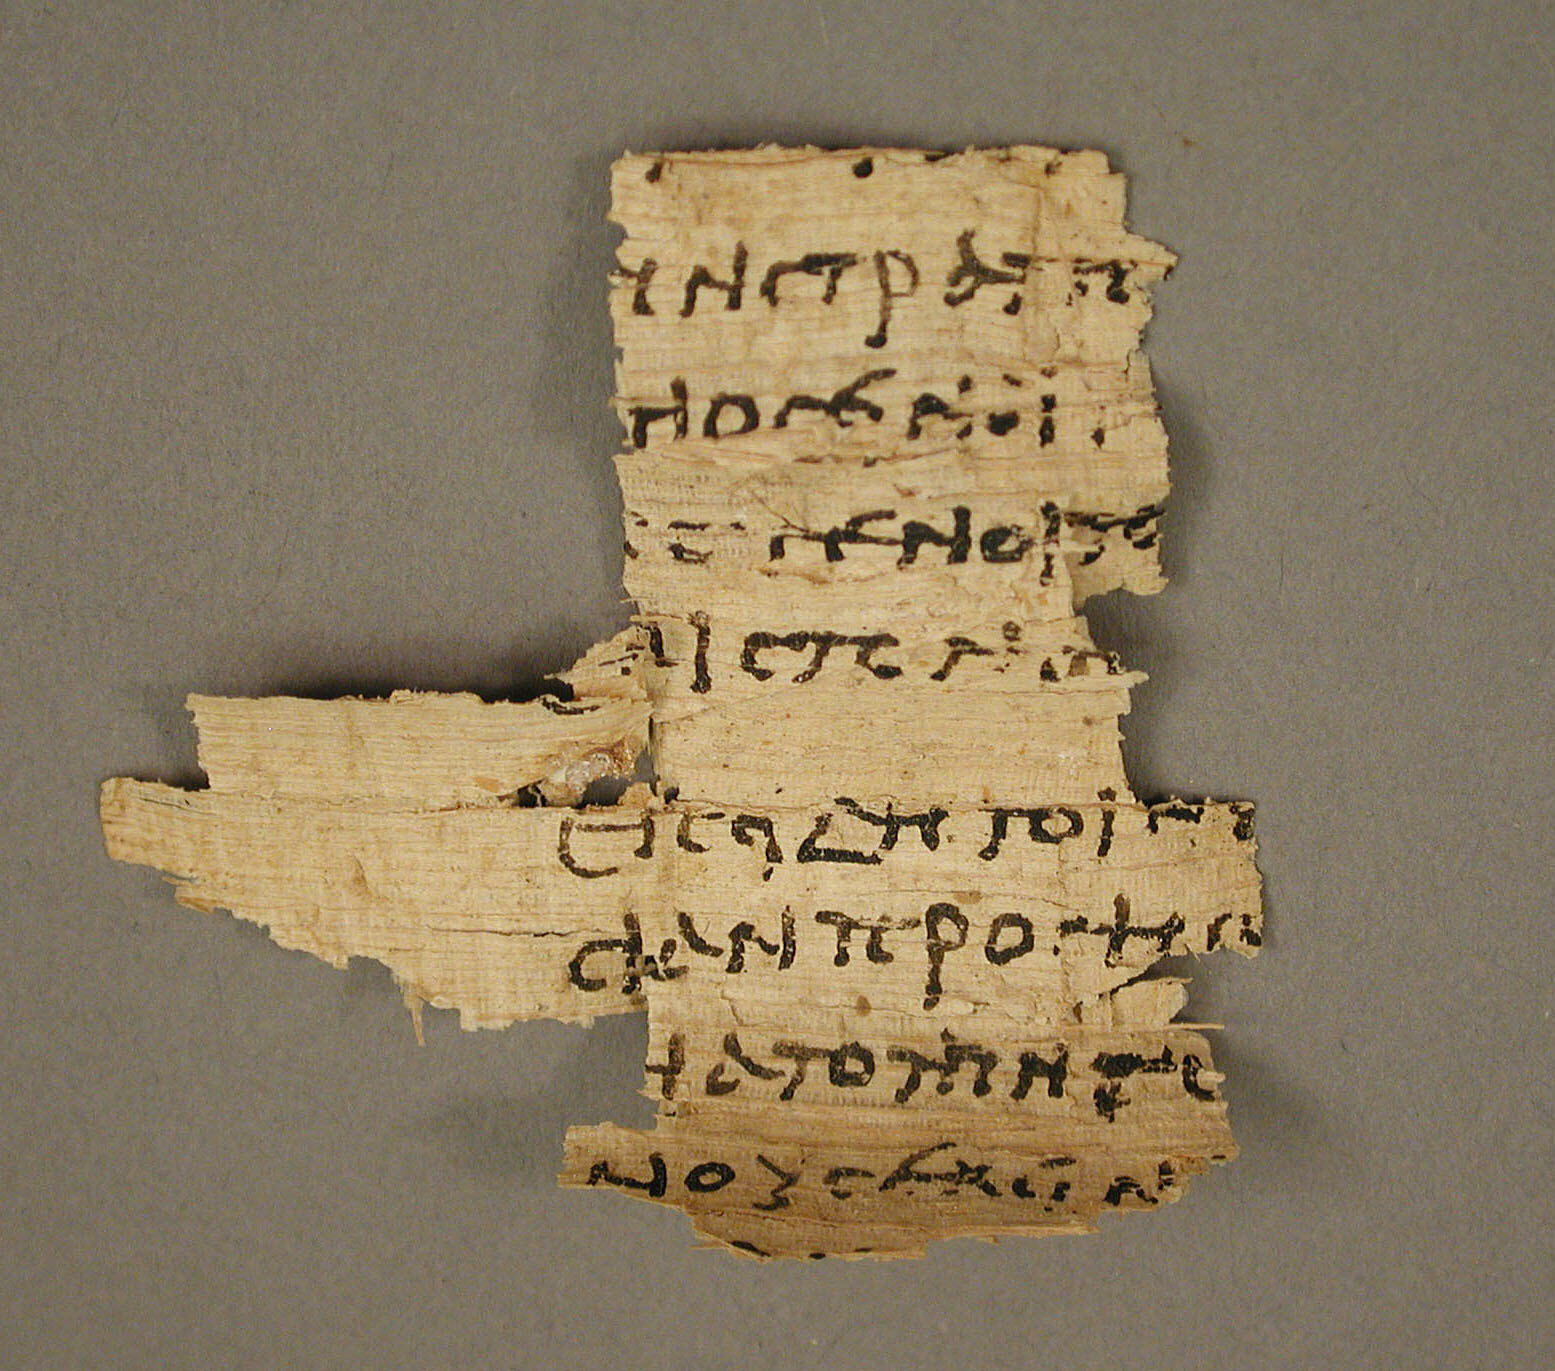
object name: fragment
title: Papyrus Fragment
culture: coptic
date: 301-700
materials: papyrus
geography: egypt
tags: documents